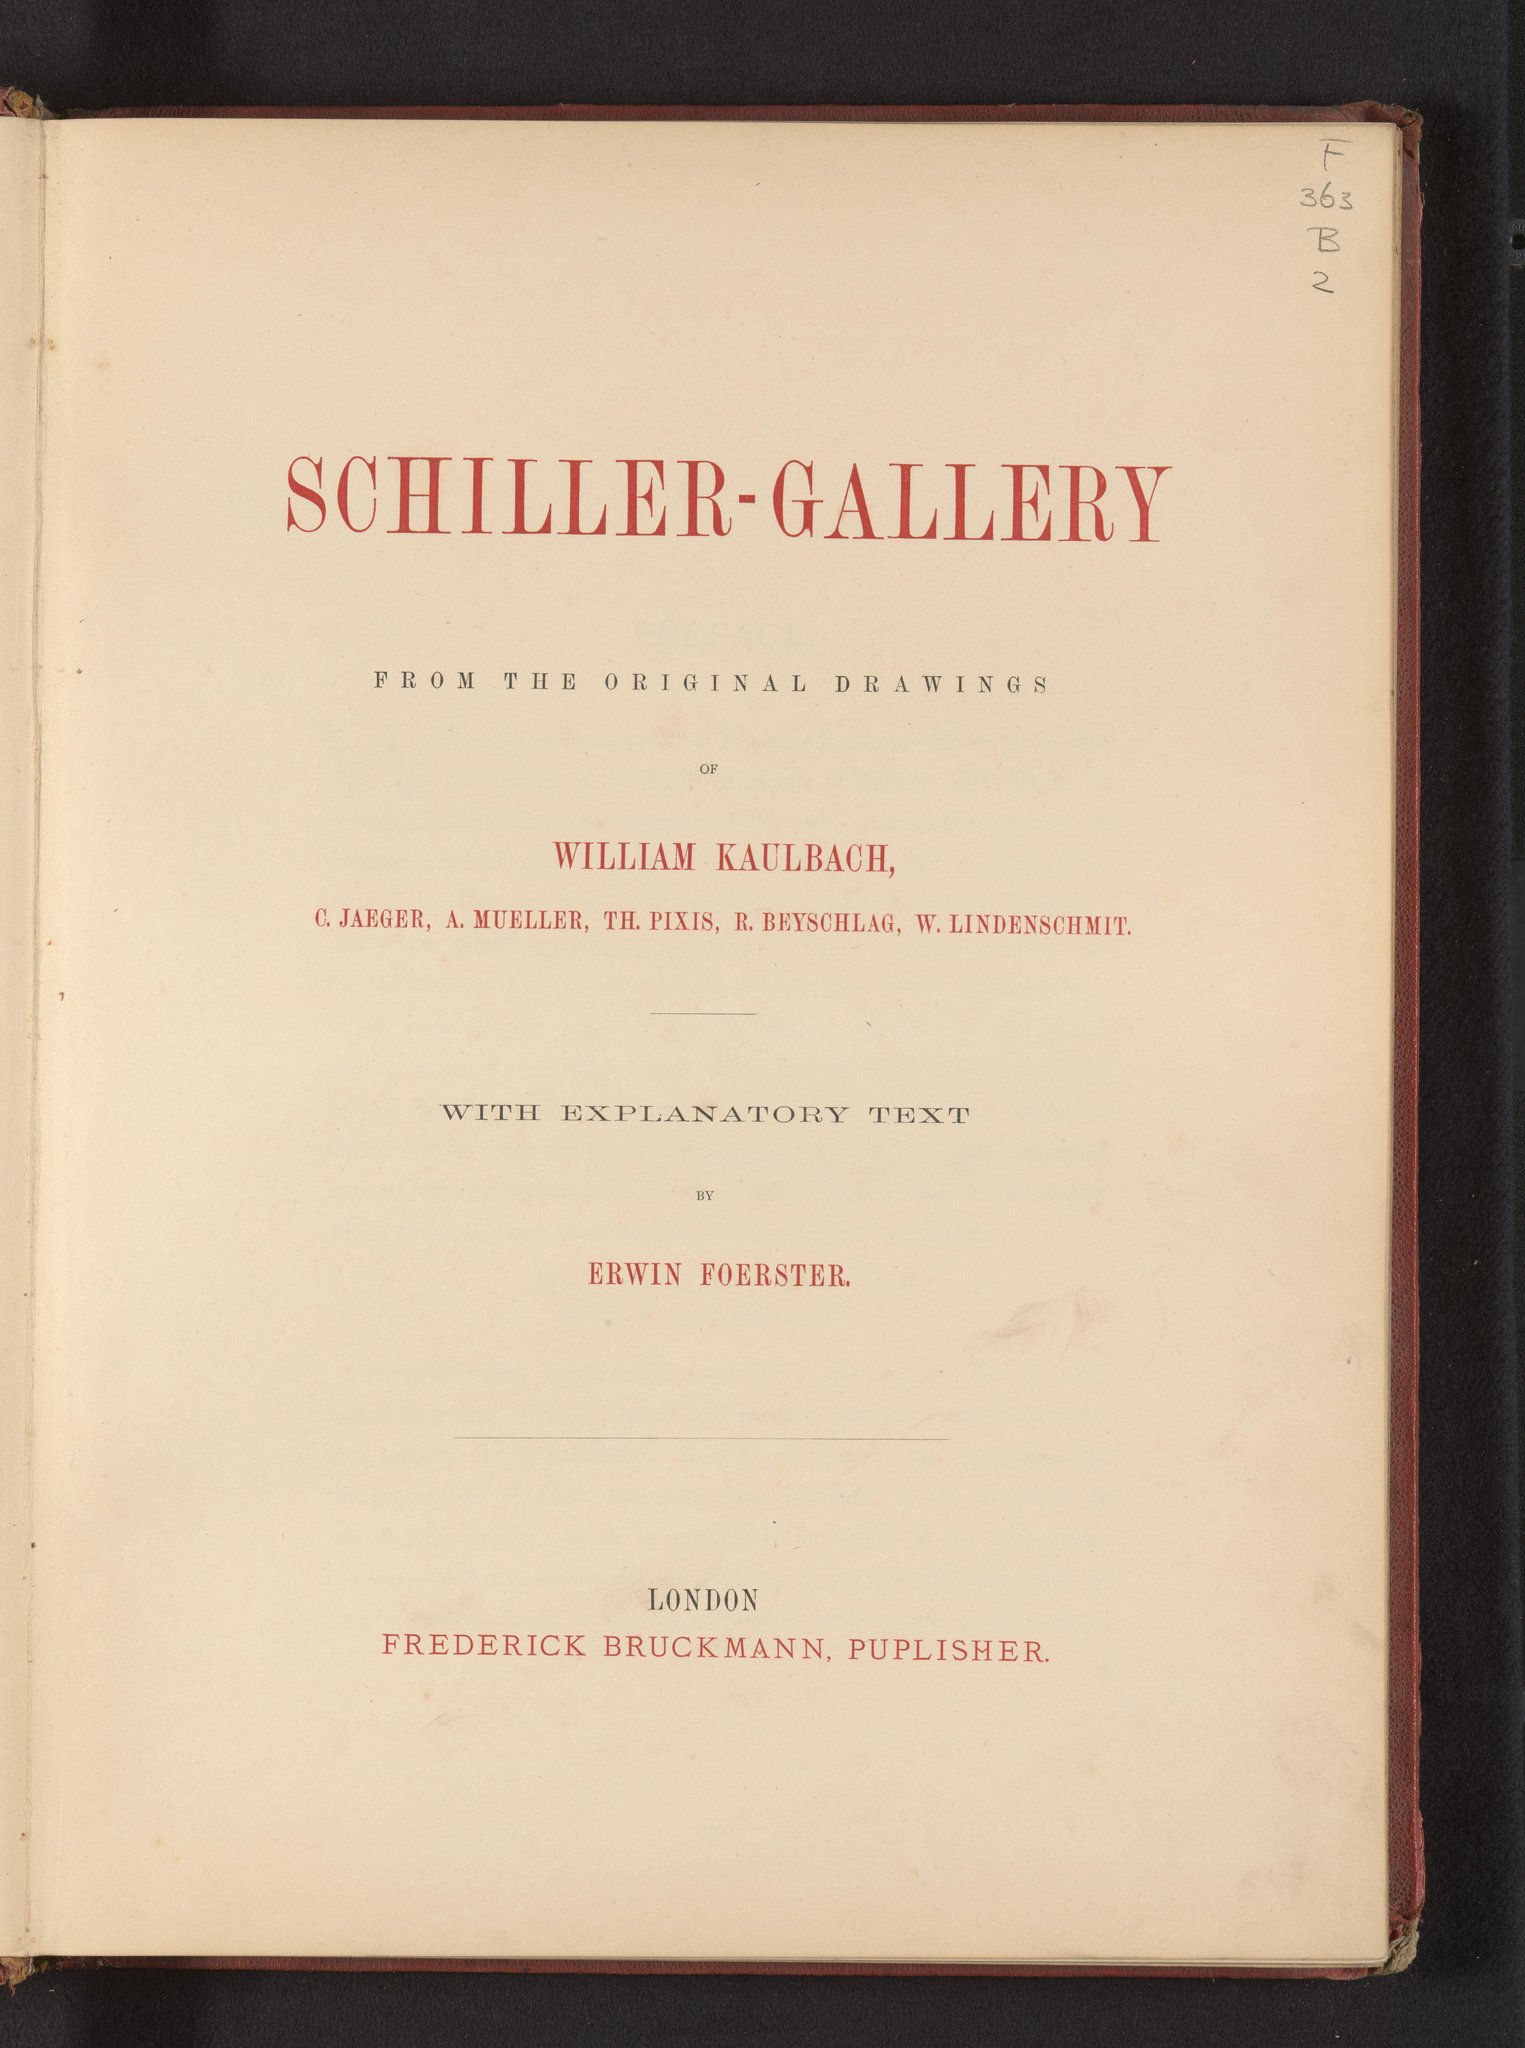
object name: book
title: Schiller-gallery / from the original drawings of William Kaulbach (...) [et al.]; with explanatory text by Erwin Foerster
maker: erwin foerster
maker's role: schrijver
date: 1875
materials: cardboard, leather, linen, paper, photographic support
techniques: albumen print, printing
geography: london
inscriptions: annotation: ‘M516/ 12-50 p.’, date: ‘MAR 1983’, bookplate: ‘EX/ SFJ/ LIBRIS’